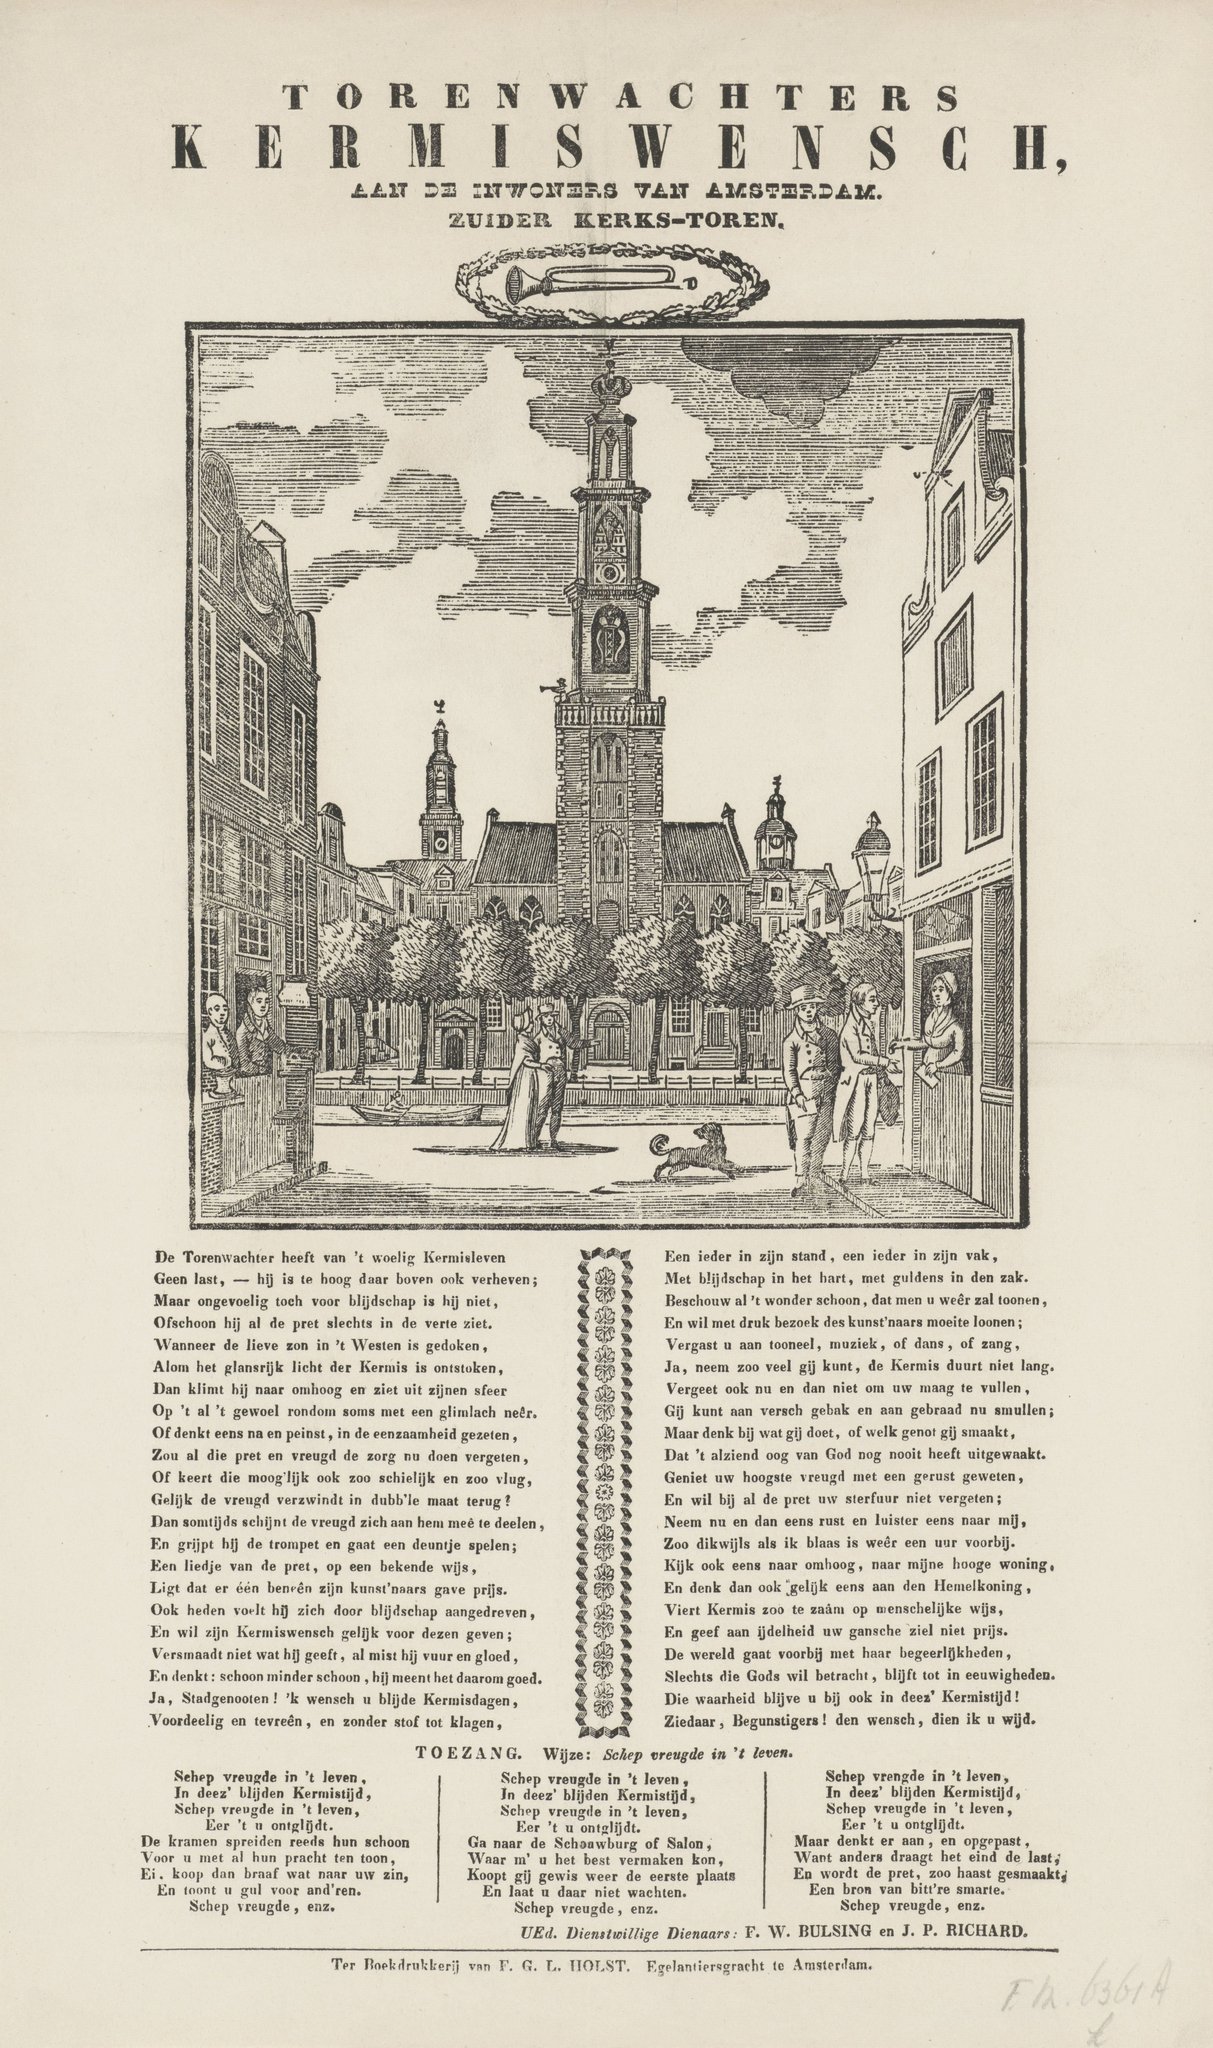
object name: print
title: Kermisprent van de torenwachters van de Zuiderkerk te Amsterdam, ca. 1840-1870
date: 1840-1870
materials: paper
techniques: letterpress printing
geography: amsterdam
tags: tower sentry, street, amsterdam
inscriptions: collector's mark: Lugt 2228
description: Kermisprent van de torenwachters van de Amsterdamse Zuiderkerk, ca. 1840-1870. Gezicht op de Westerkerk te Amsterdam, twee mannen halen aan de huizen geld op. Onderaan een gedicht in twee kolommen en een lied in drie verzen. Van de torenwachters: F.W. Bulsing en J.P. Richard.